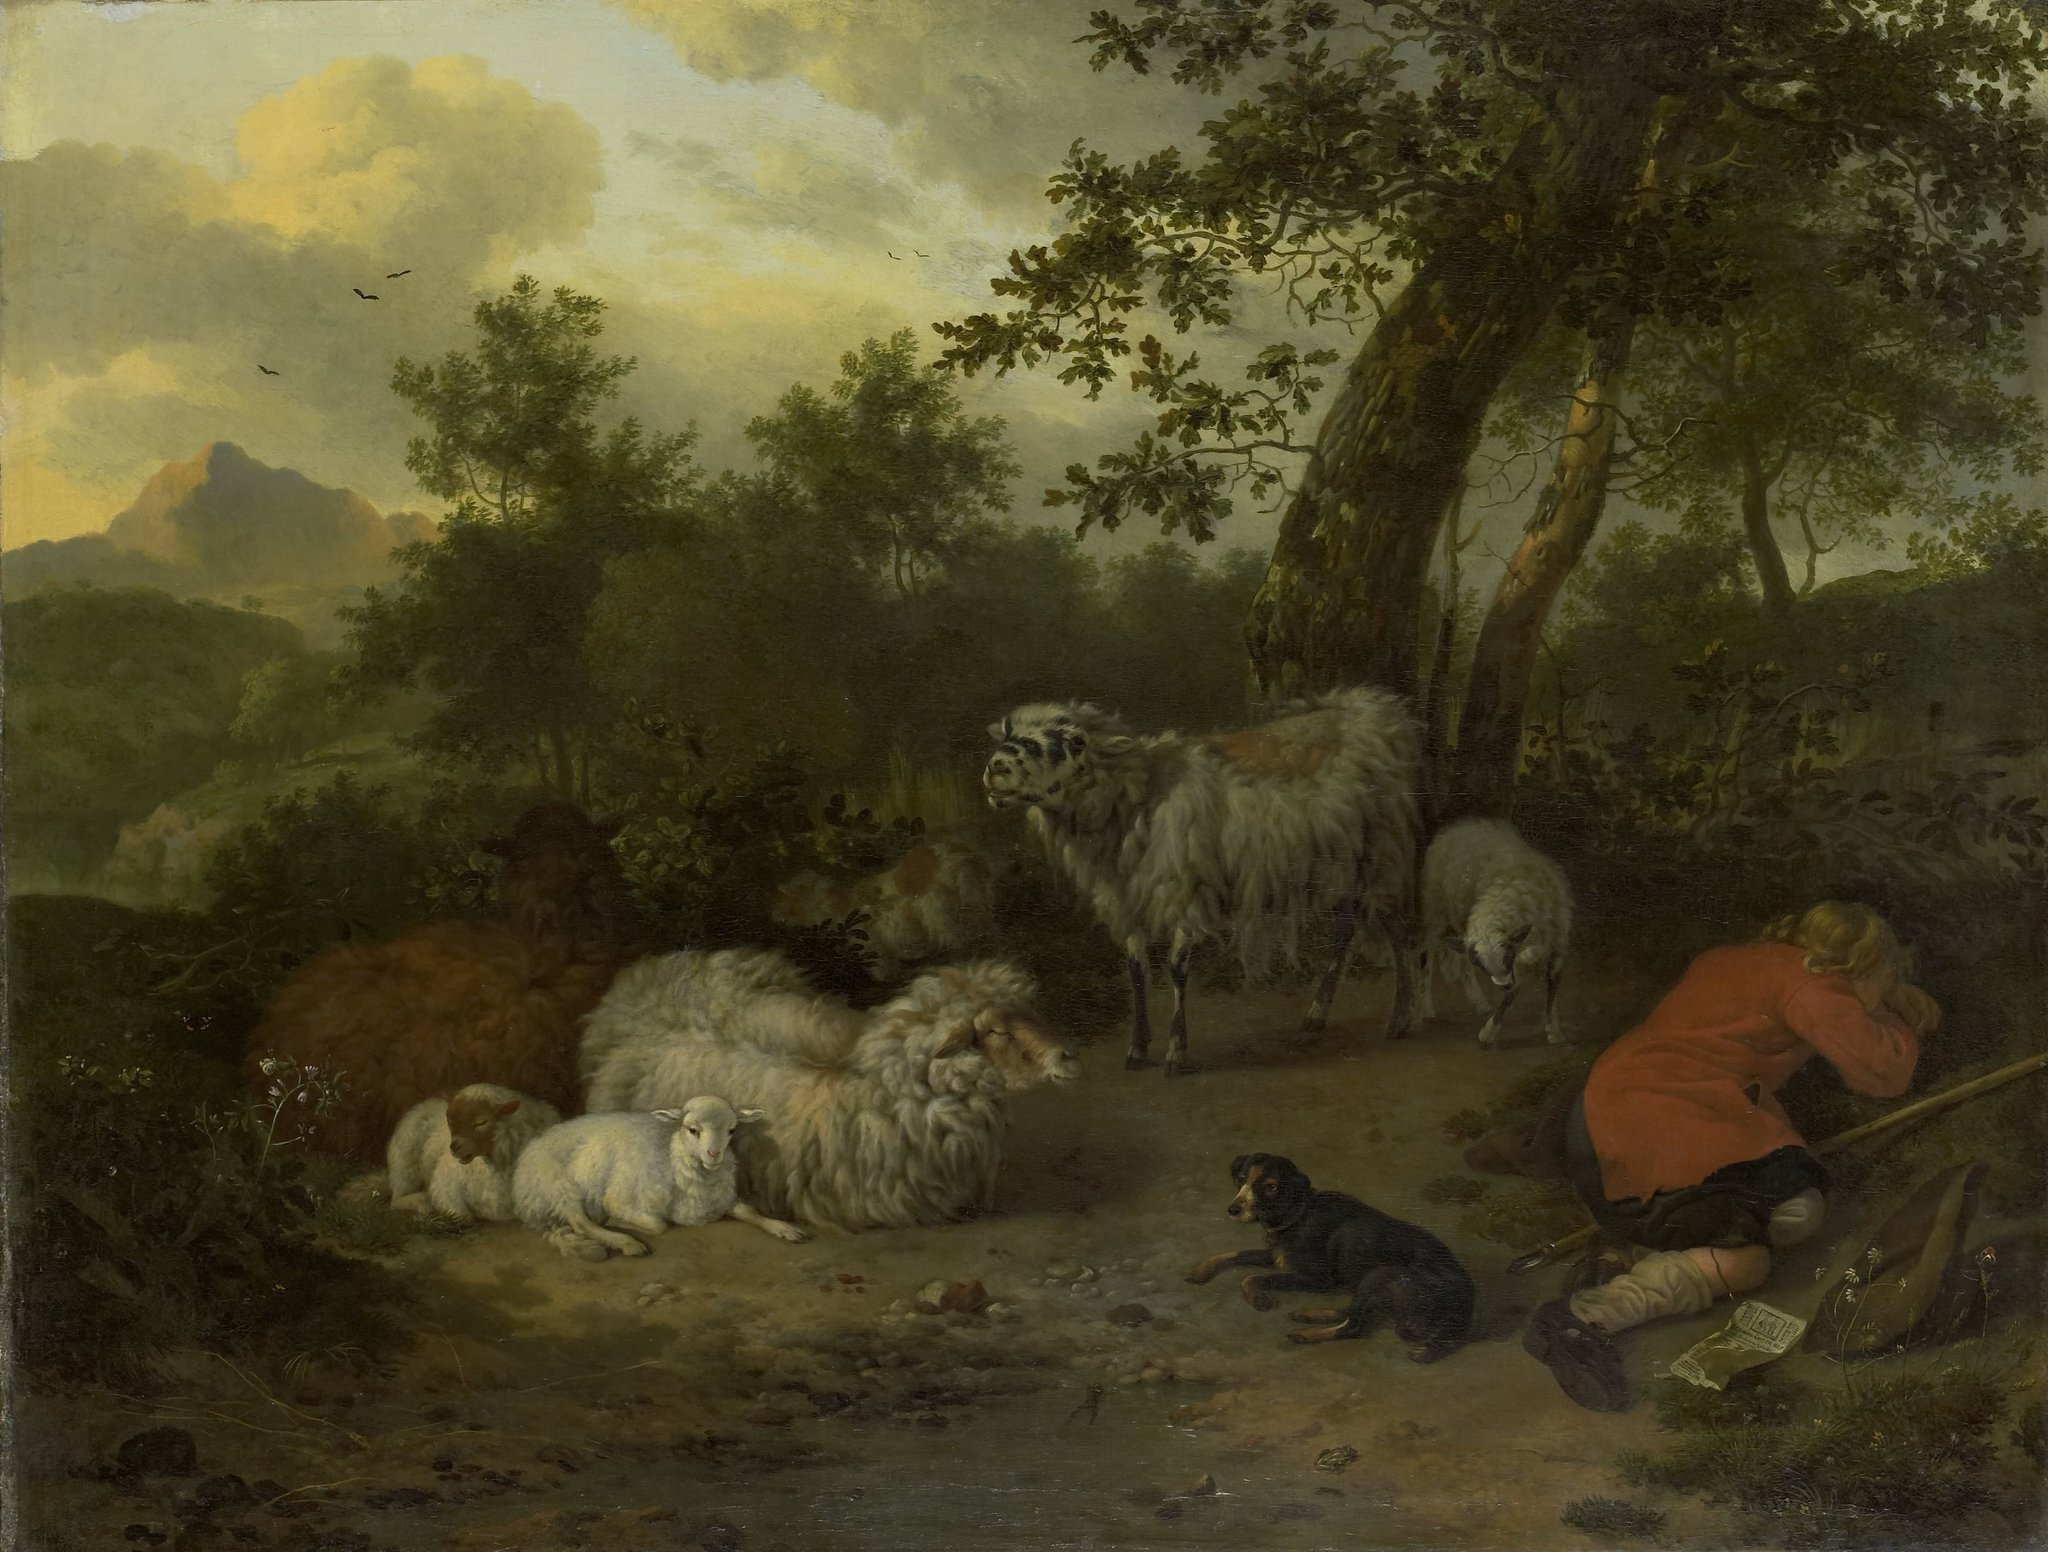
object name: painting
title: The Sleeping Shepherd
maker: jan van der meer (ii)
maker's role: draughtsman, print maker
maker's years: 1656-1705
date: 1678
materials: canvas, oil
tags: herding, herdsman, herdswoman, shepherd, shepherdess, cowherd, etc., sleeping on the ground - bb - out of doors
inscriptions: signature and date: ‘J. v.d. Meer de J. Aº 1678.’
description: Landschap met een slapende herder. Links de schapen en een hond. Naast de herder liggen zijn hoed en een geïllustreerd pamflet.